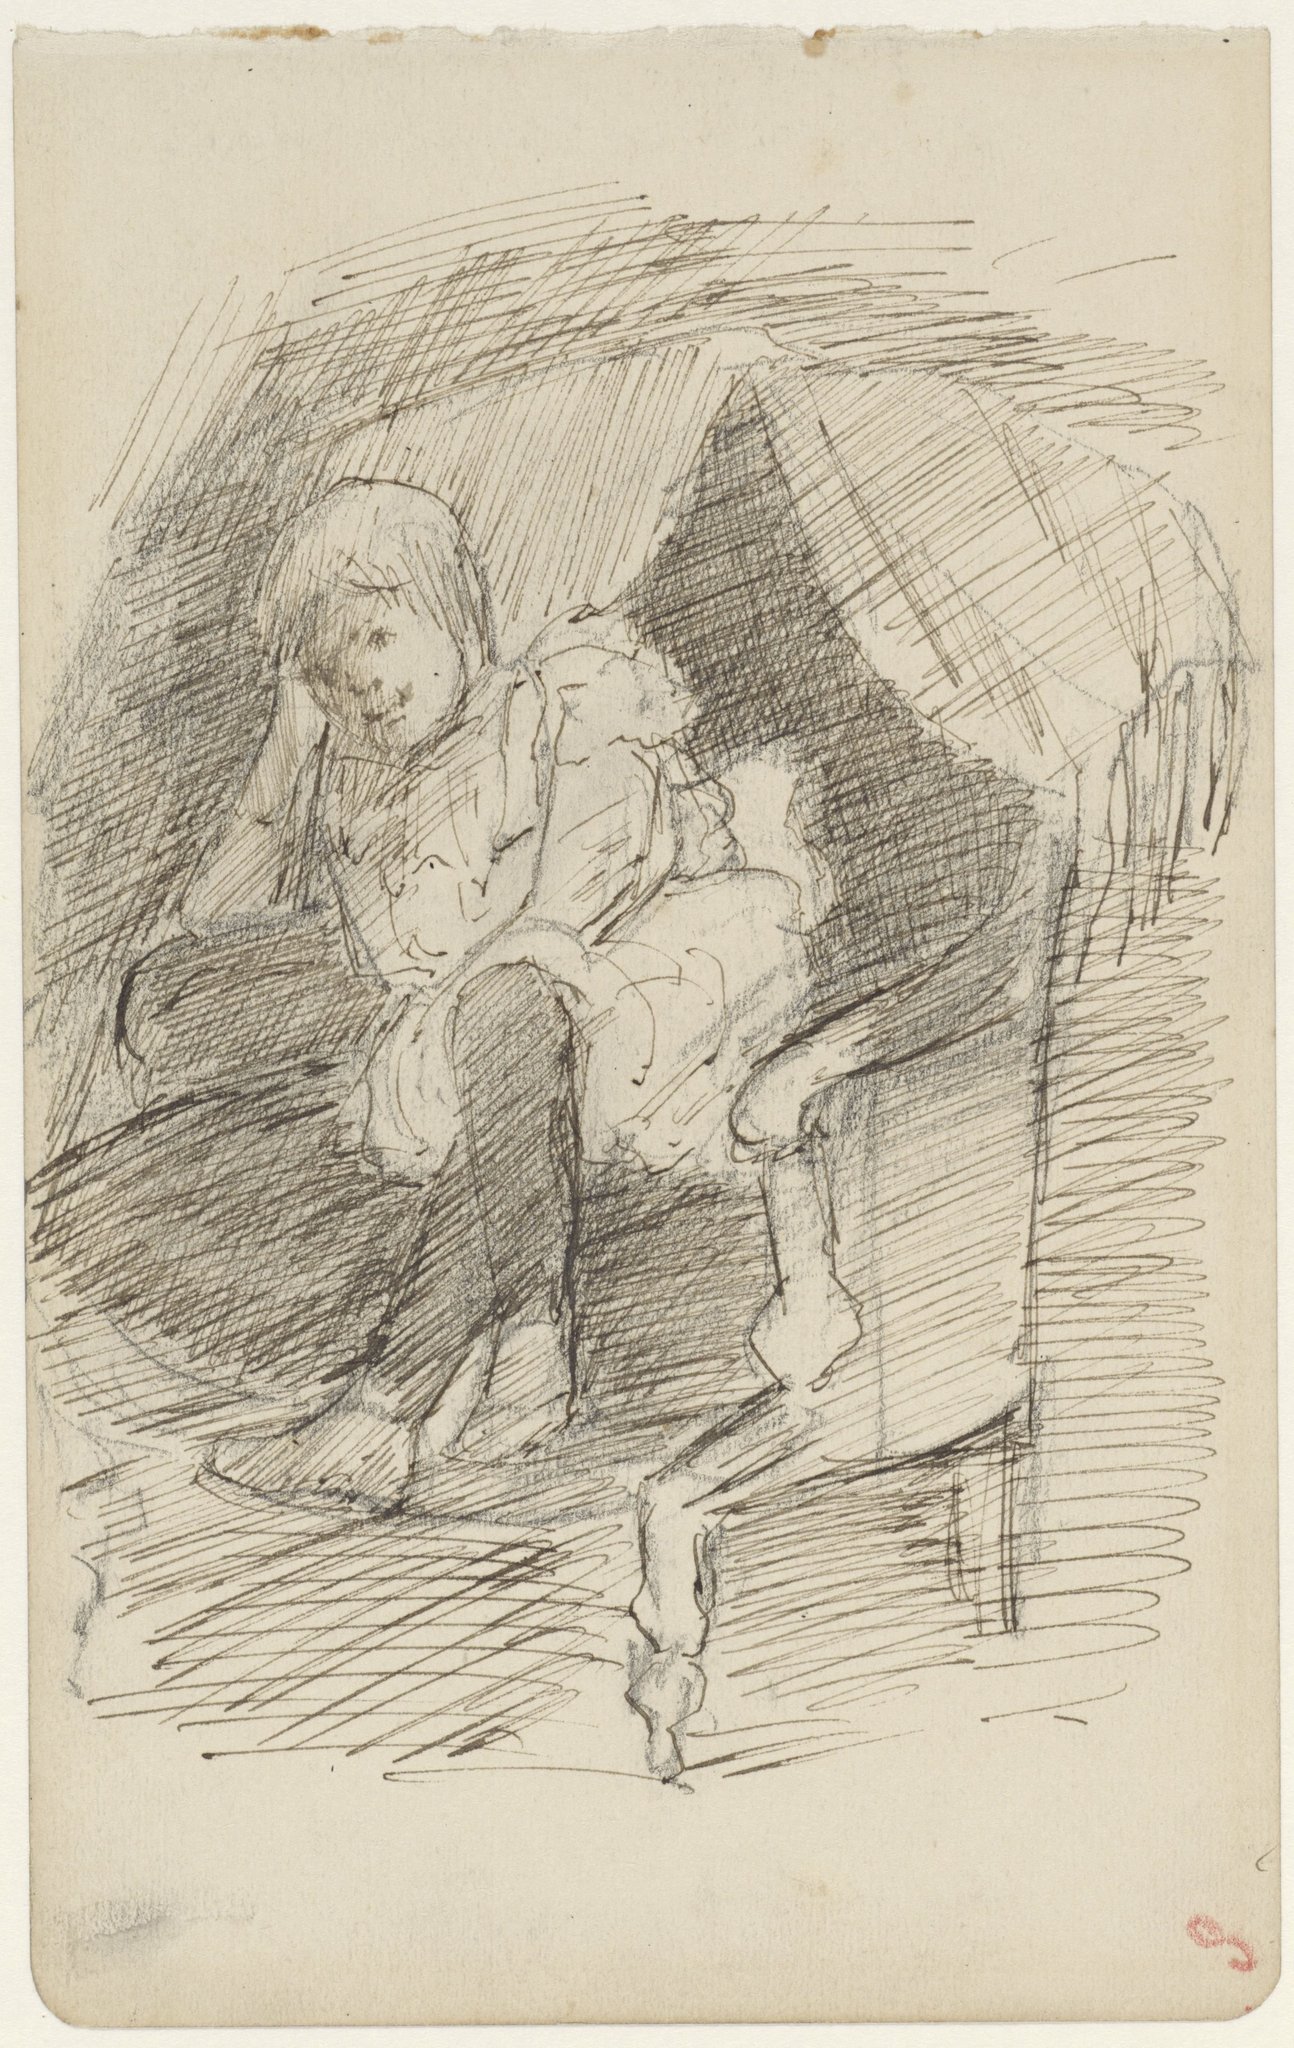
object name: drawing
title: Meisje in een stoel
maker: jozef israëls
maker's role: draughtsman, painter, print maker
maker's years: 1824-1911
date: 1834-1911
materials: ink, paper, pencil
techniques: pen